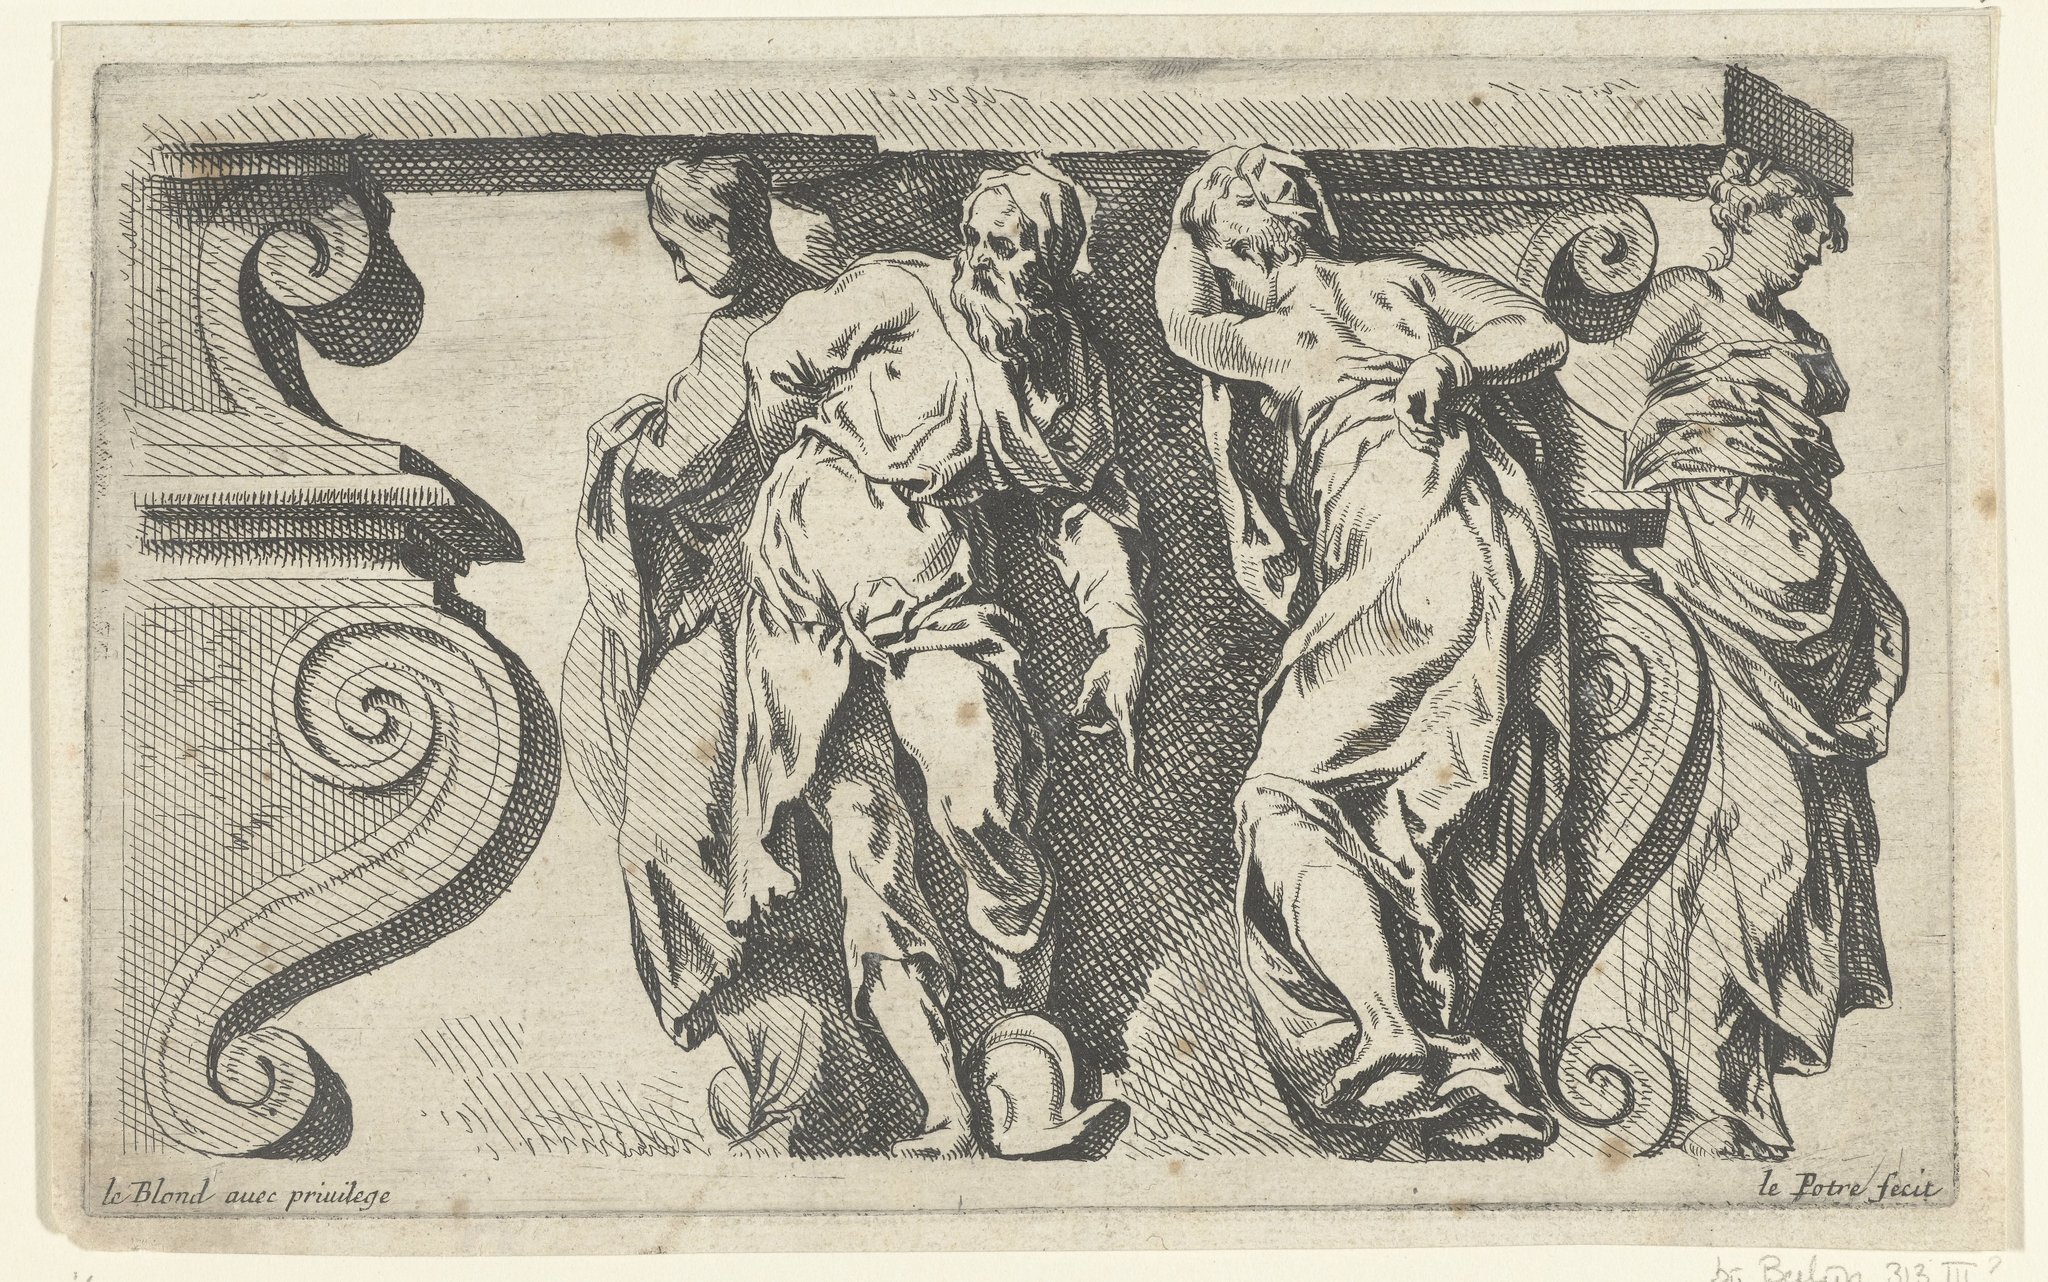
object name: print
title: Vier kariatiden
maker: jean lepautre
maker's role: draughtsman, print maker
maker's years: 1618-1682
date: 1650-1666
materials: paper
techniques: etching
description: Drie vrouwen en een man ondersteunen een kroonlijst. Vierde blad uit serie van 5, eerste editie.